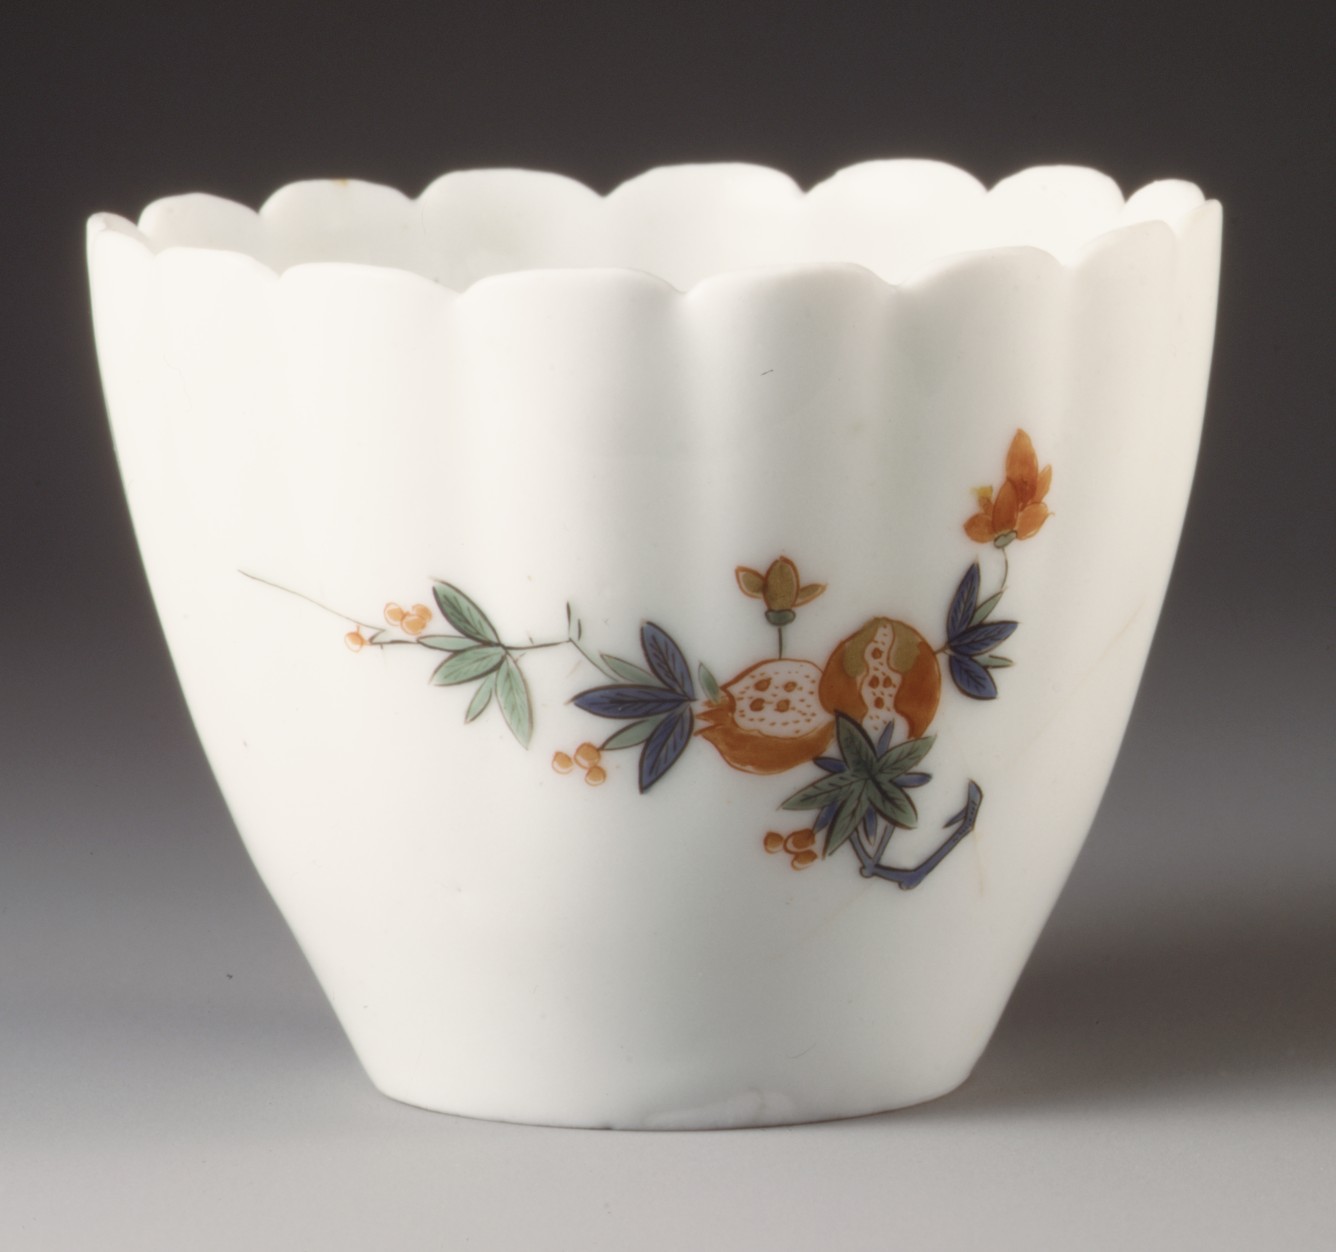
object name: cup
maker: meissen manufactory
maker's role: manufactory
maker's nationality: german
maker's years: 1710-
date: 1730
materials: hard paste porcelain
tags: fruit